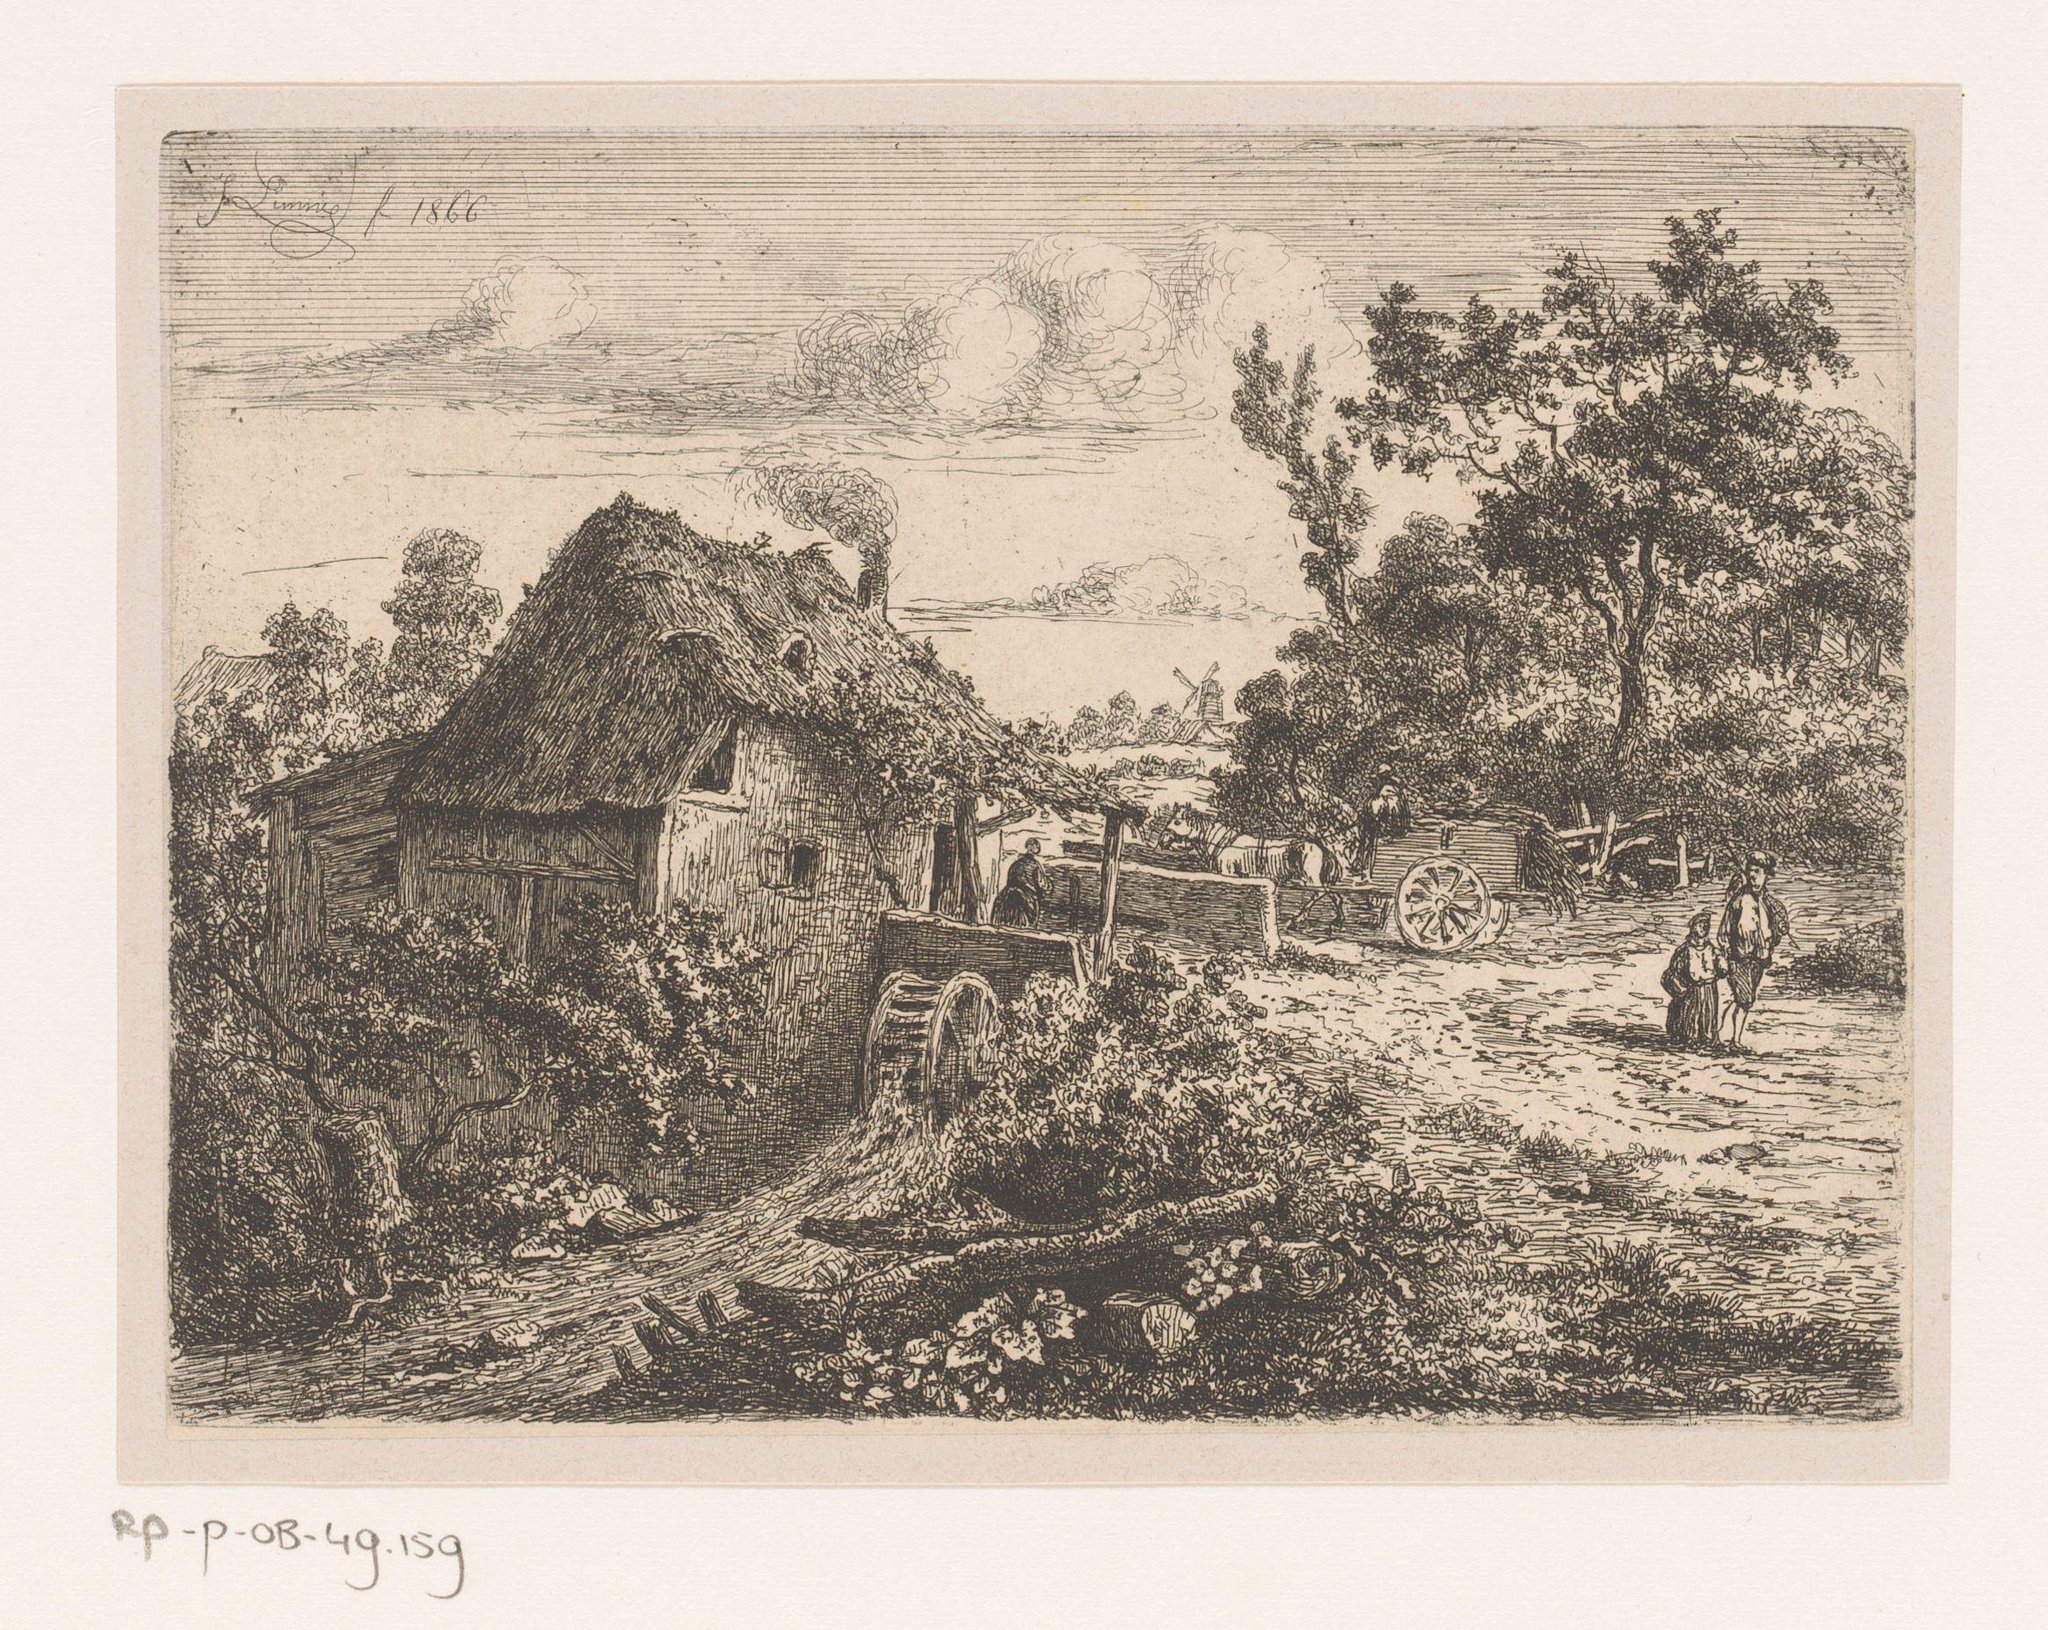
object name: print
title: Watermolen in Sint-Josse-ten-Node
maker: jean théodore joseph linnig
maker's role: draughtsman, print maker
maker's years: 1815-1891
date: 1866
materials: paper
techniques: etching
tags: watermill in landscape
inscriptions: date